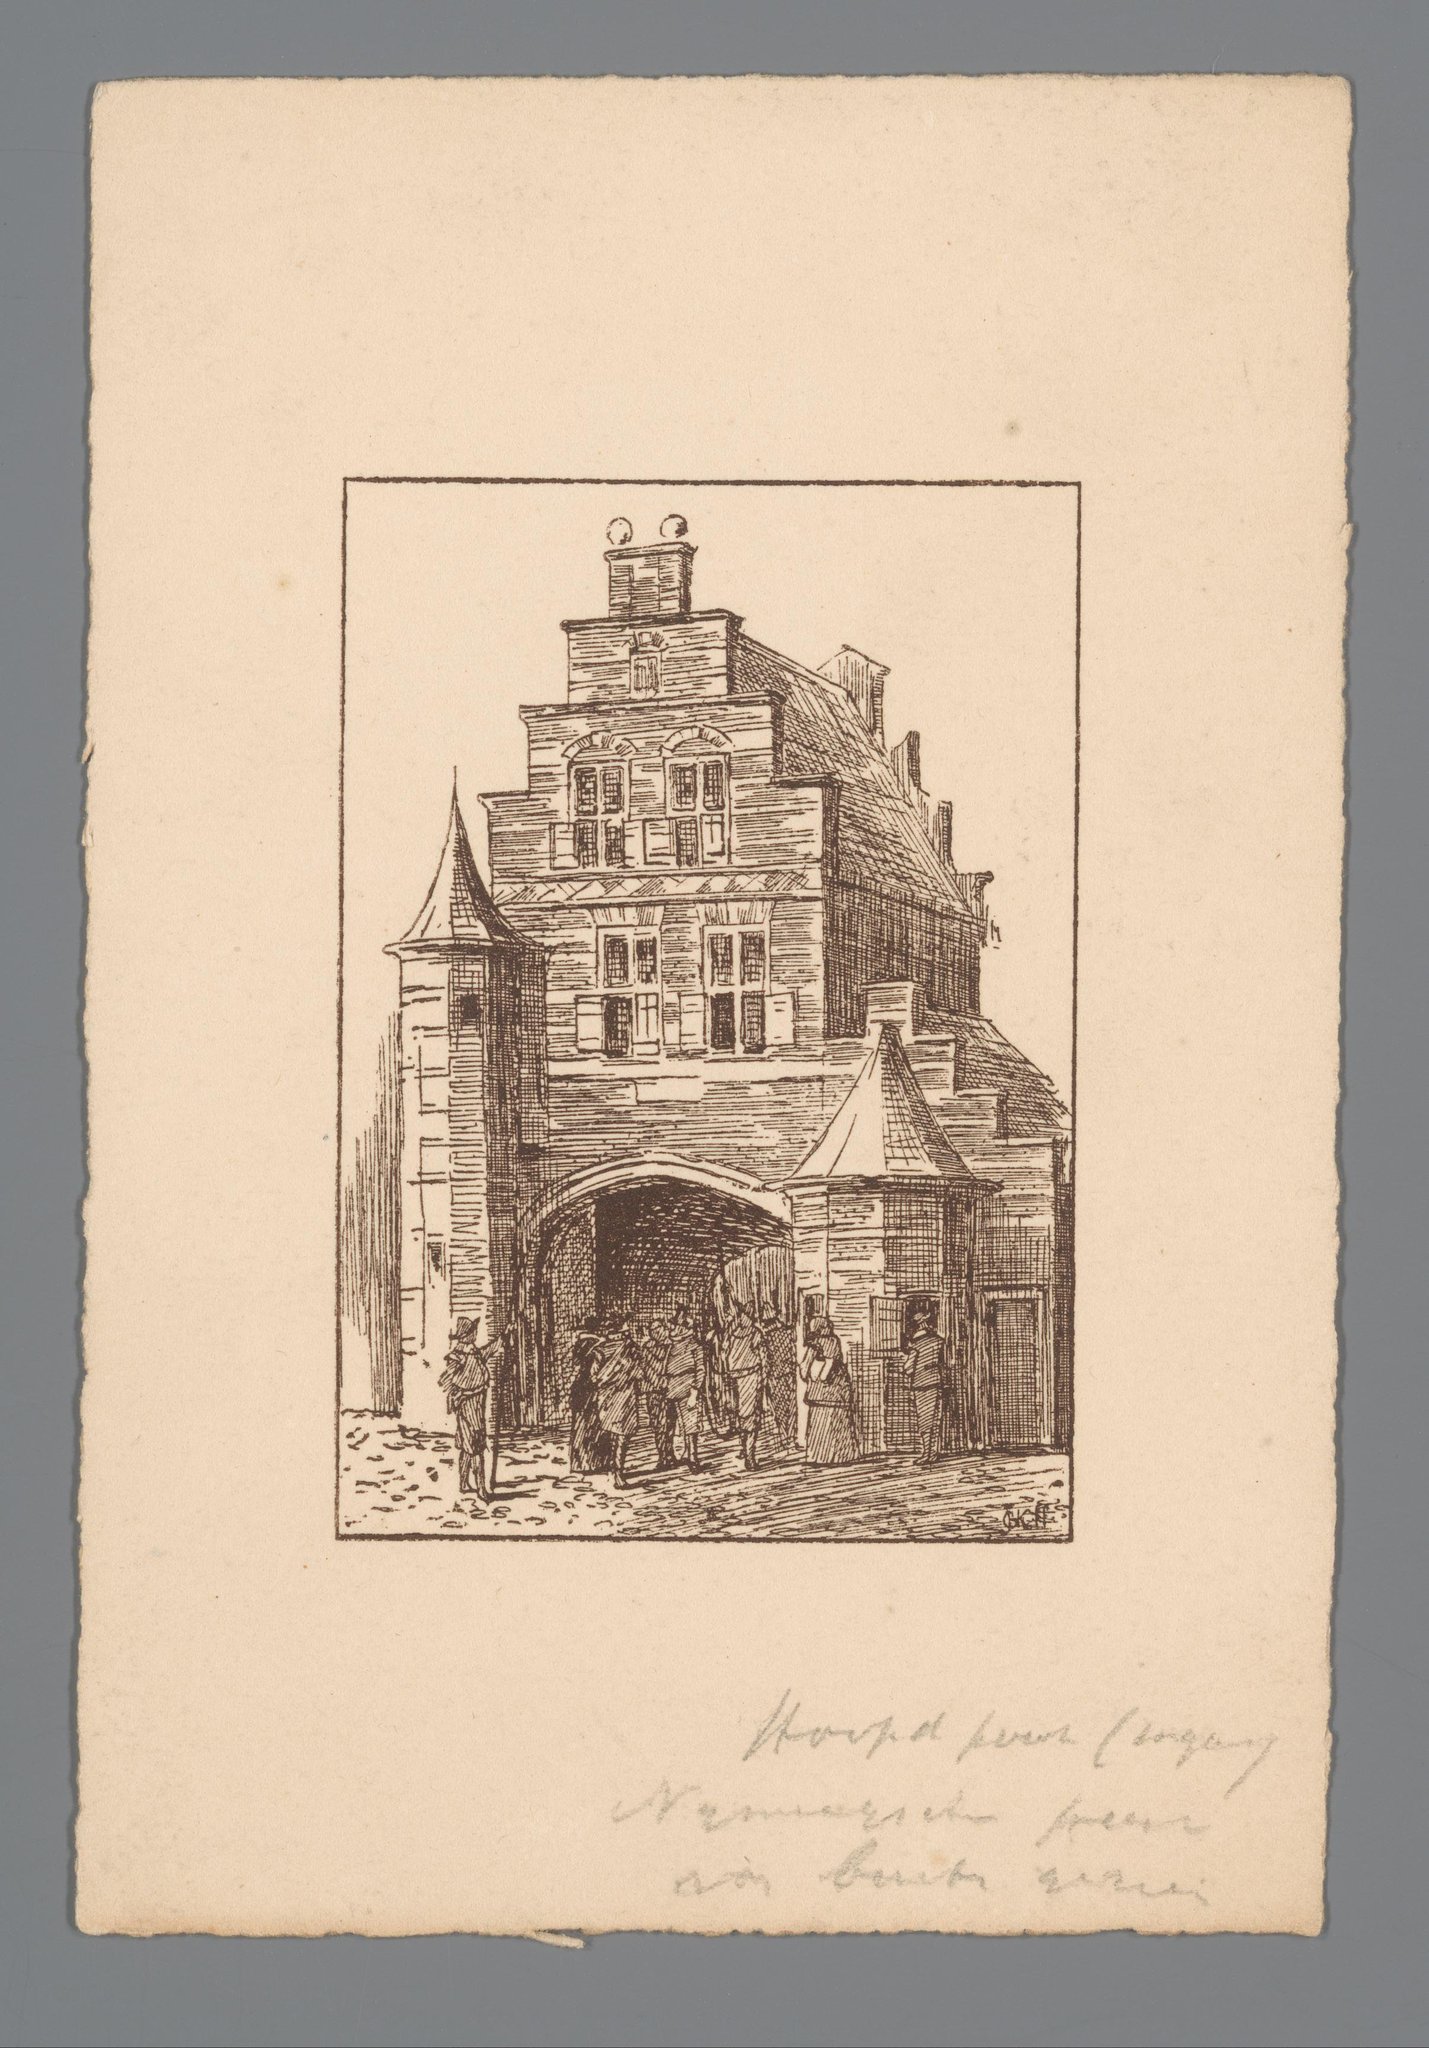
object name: print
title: Gezicht op een stadspoort in Nijmegen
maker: Anonymous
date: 1850-1900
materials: paper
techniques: lithograph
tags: city-gate, nijmegen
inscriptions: monogram: ‘CHCH [?]’